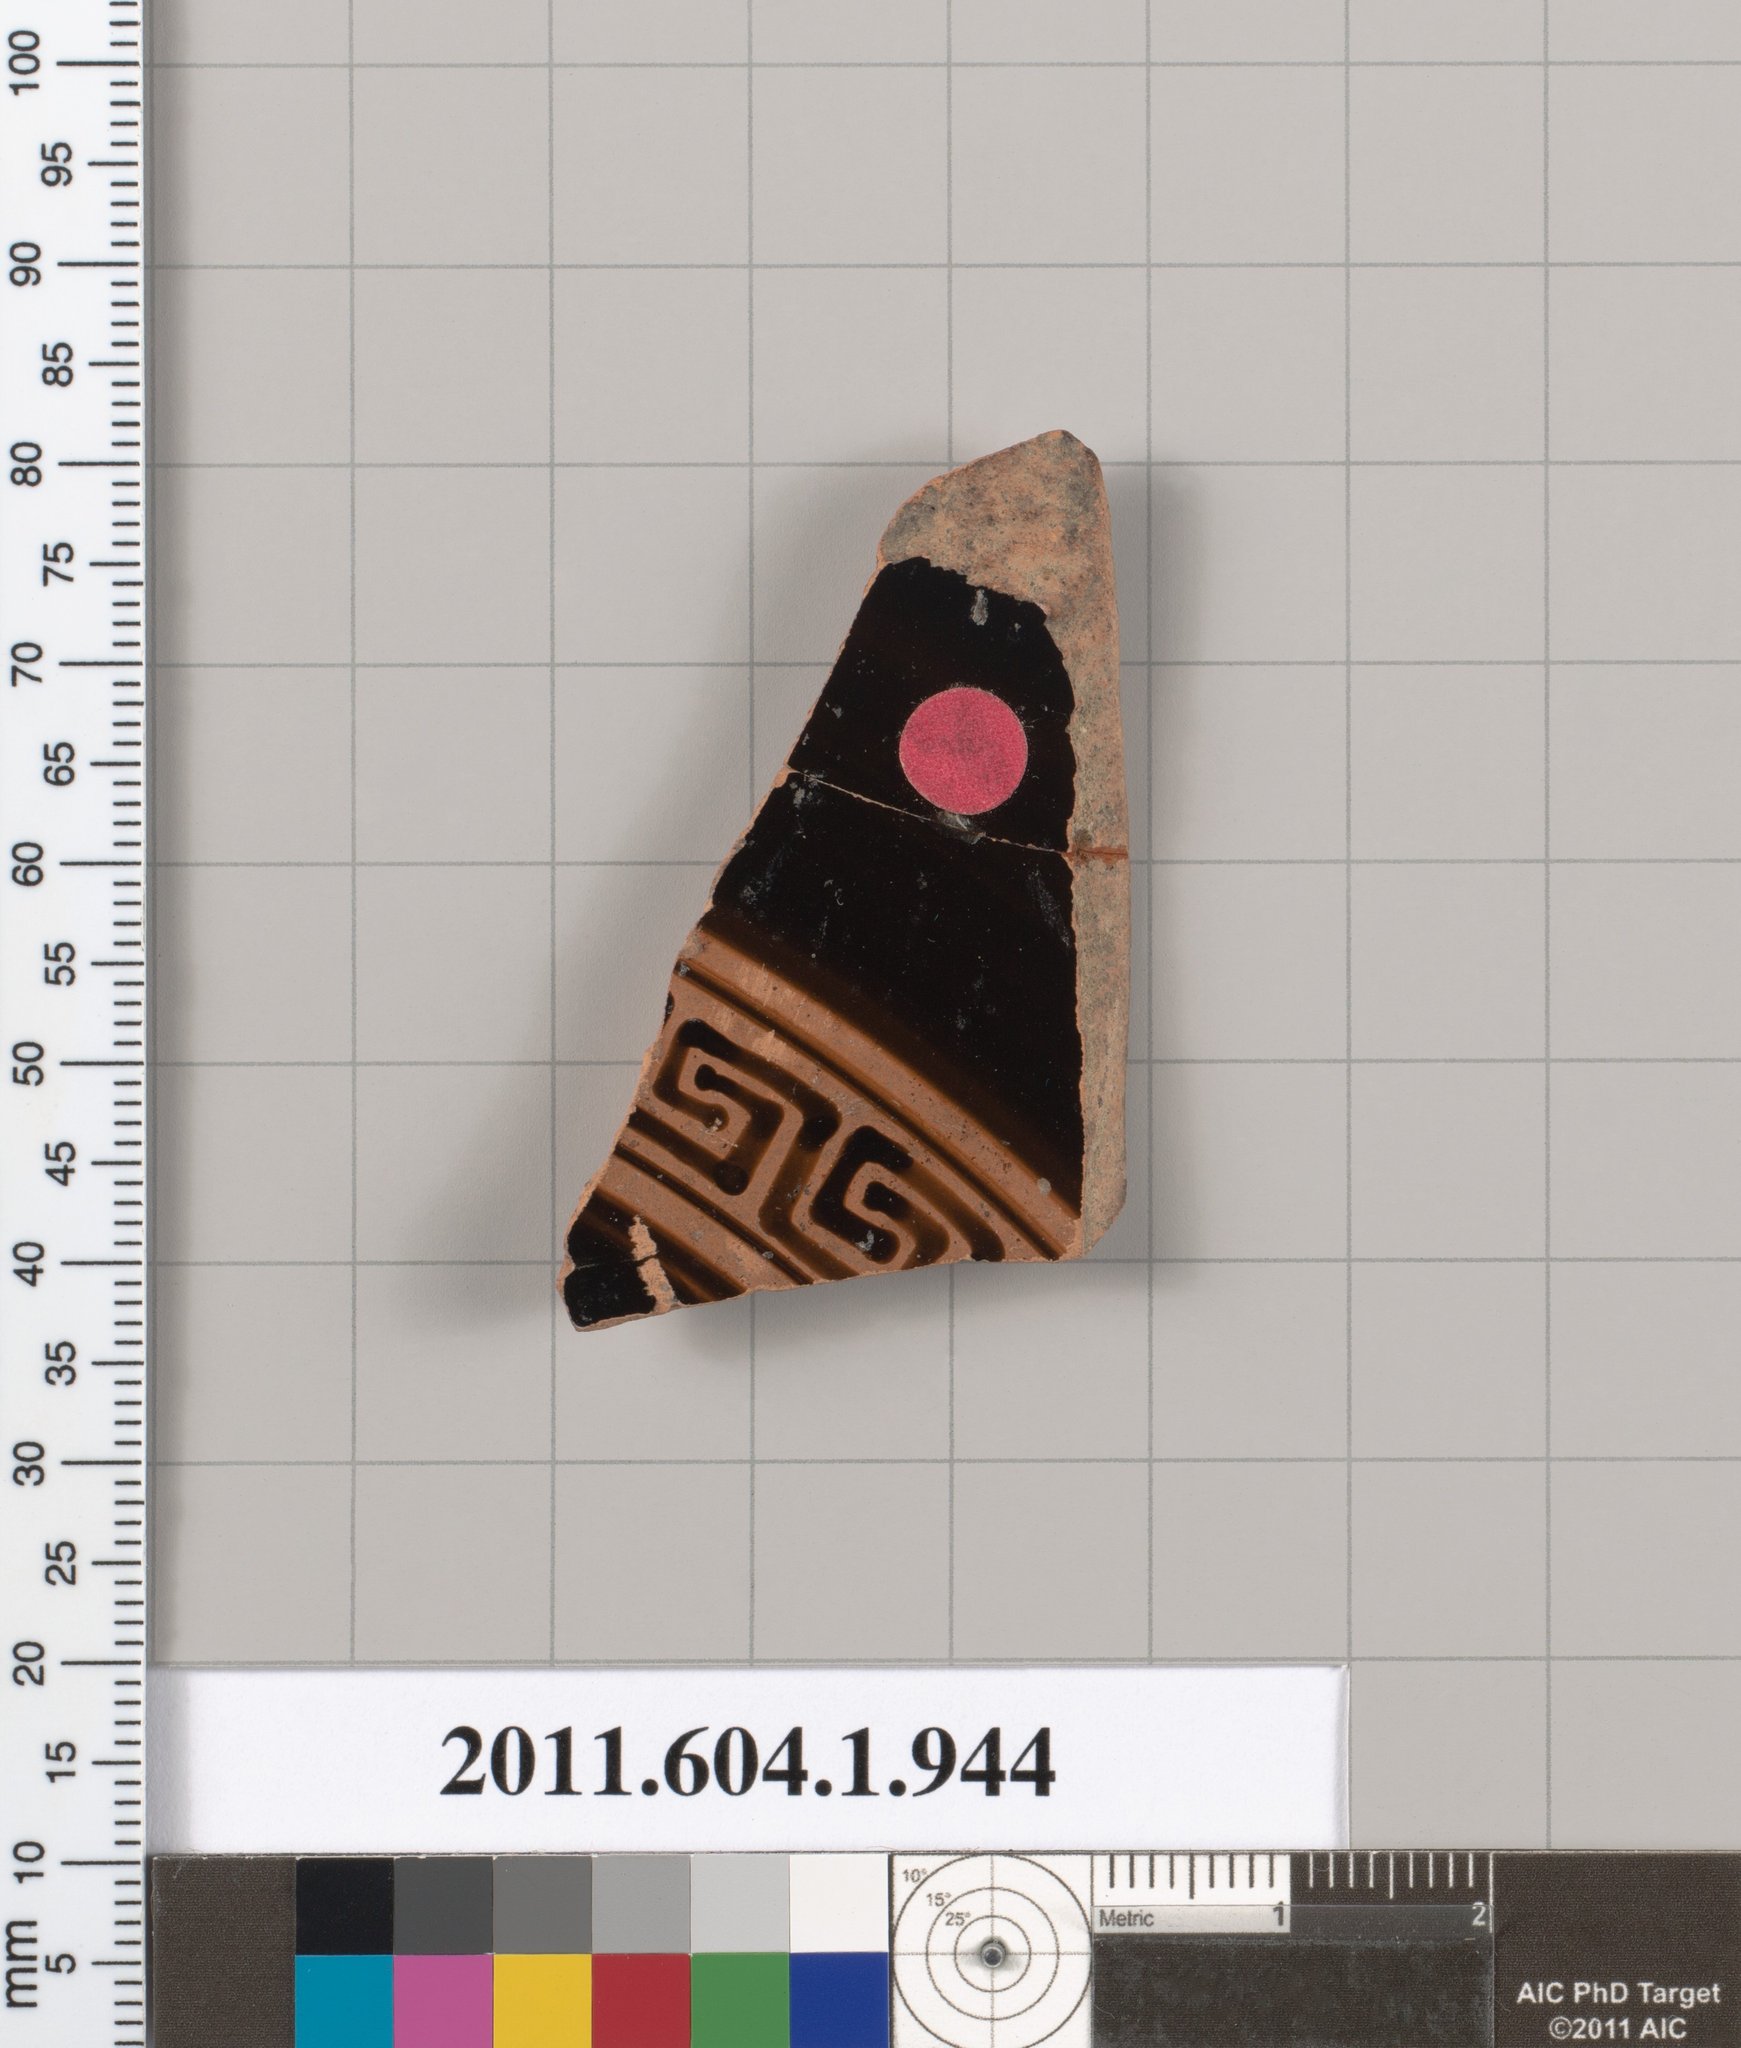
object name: kylix fragment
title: Terracotta fragment of a kylix (drinking cup)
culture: greek, attic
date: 490-480 BCE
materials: terracotta